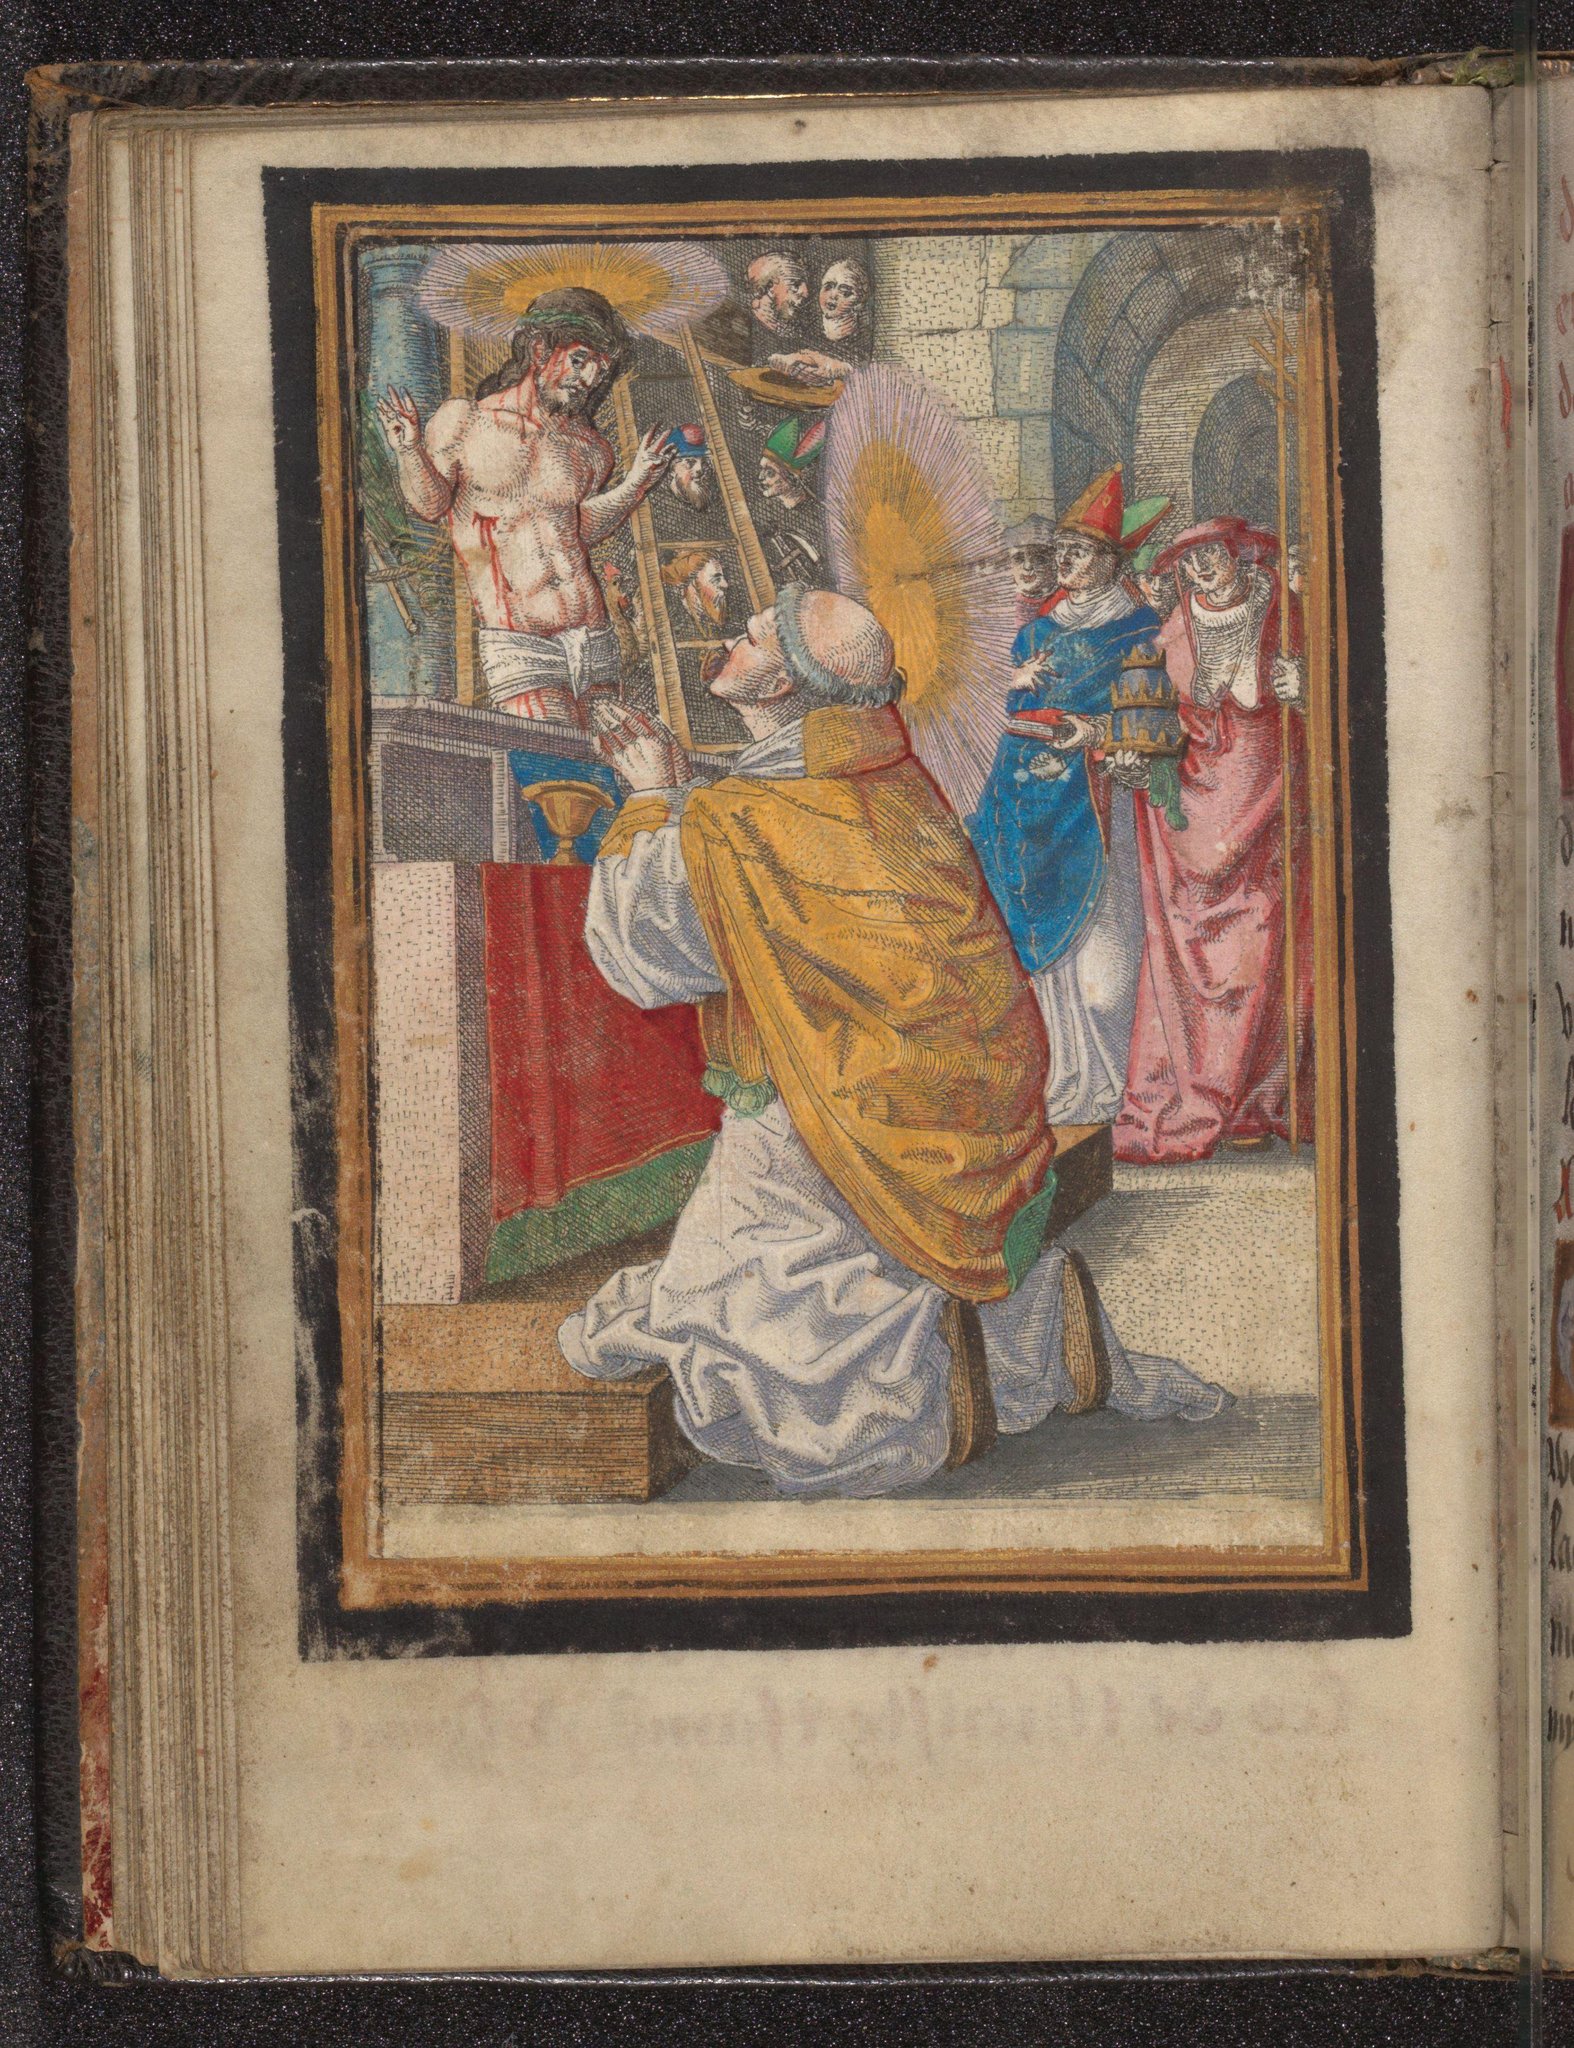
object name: page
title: Mis van Gregorius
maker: frans crabbe van espleghem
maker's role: print maker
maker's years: 1480-1552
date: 1497-1552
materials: paper, parchment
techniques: engraving, etching, hand coloring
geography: mechelen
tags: man of sorrows, 'imago pietatis', 'erbärmdebild', 'schmerzensmann'; the upright christ showing his wounds, usually bearing the crown of thorns, and accompanied by the instruments of the passion, standing or sitting in his tomb, the mass of st. gregory the great: christ appears above the altar with the instruments of the passion; maybe blood spouts from christ's side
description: Gregorius zit op zijn knieën voor het altaar. Op het altaar verschijnt Christus die hem zijn bloedende wonden toont. Naast Christus verschijnen de passiewerktuigen. Op de achtergrond geestelijken. Een kardinaal draagt de pauselijke tiara van Gregorius. Deze prent maakt deel uit van een handgeschreven gebedenboek.